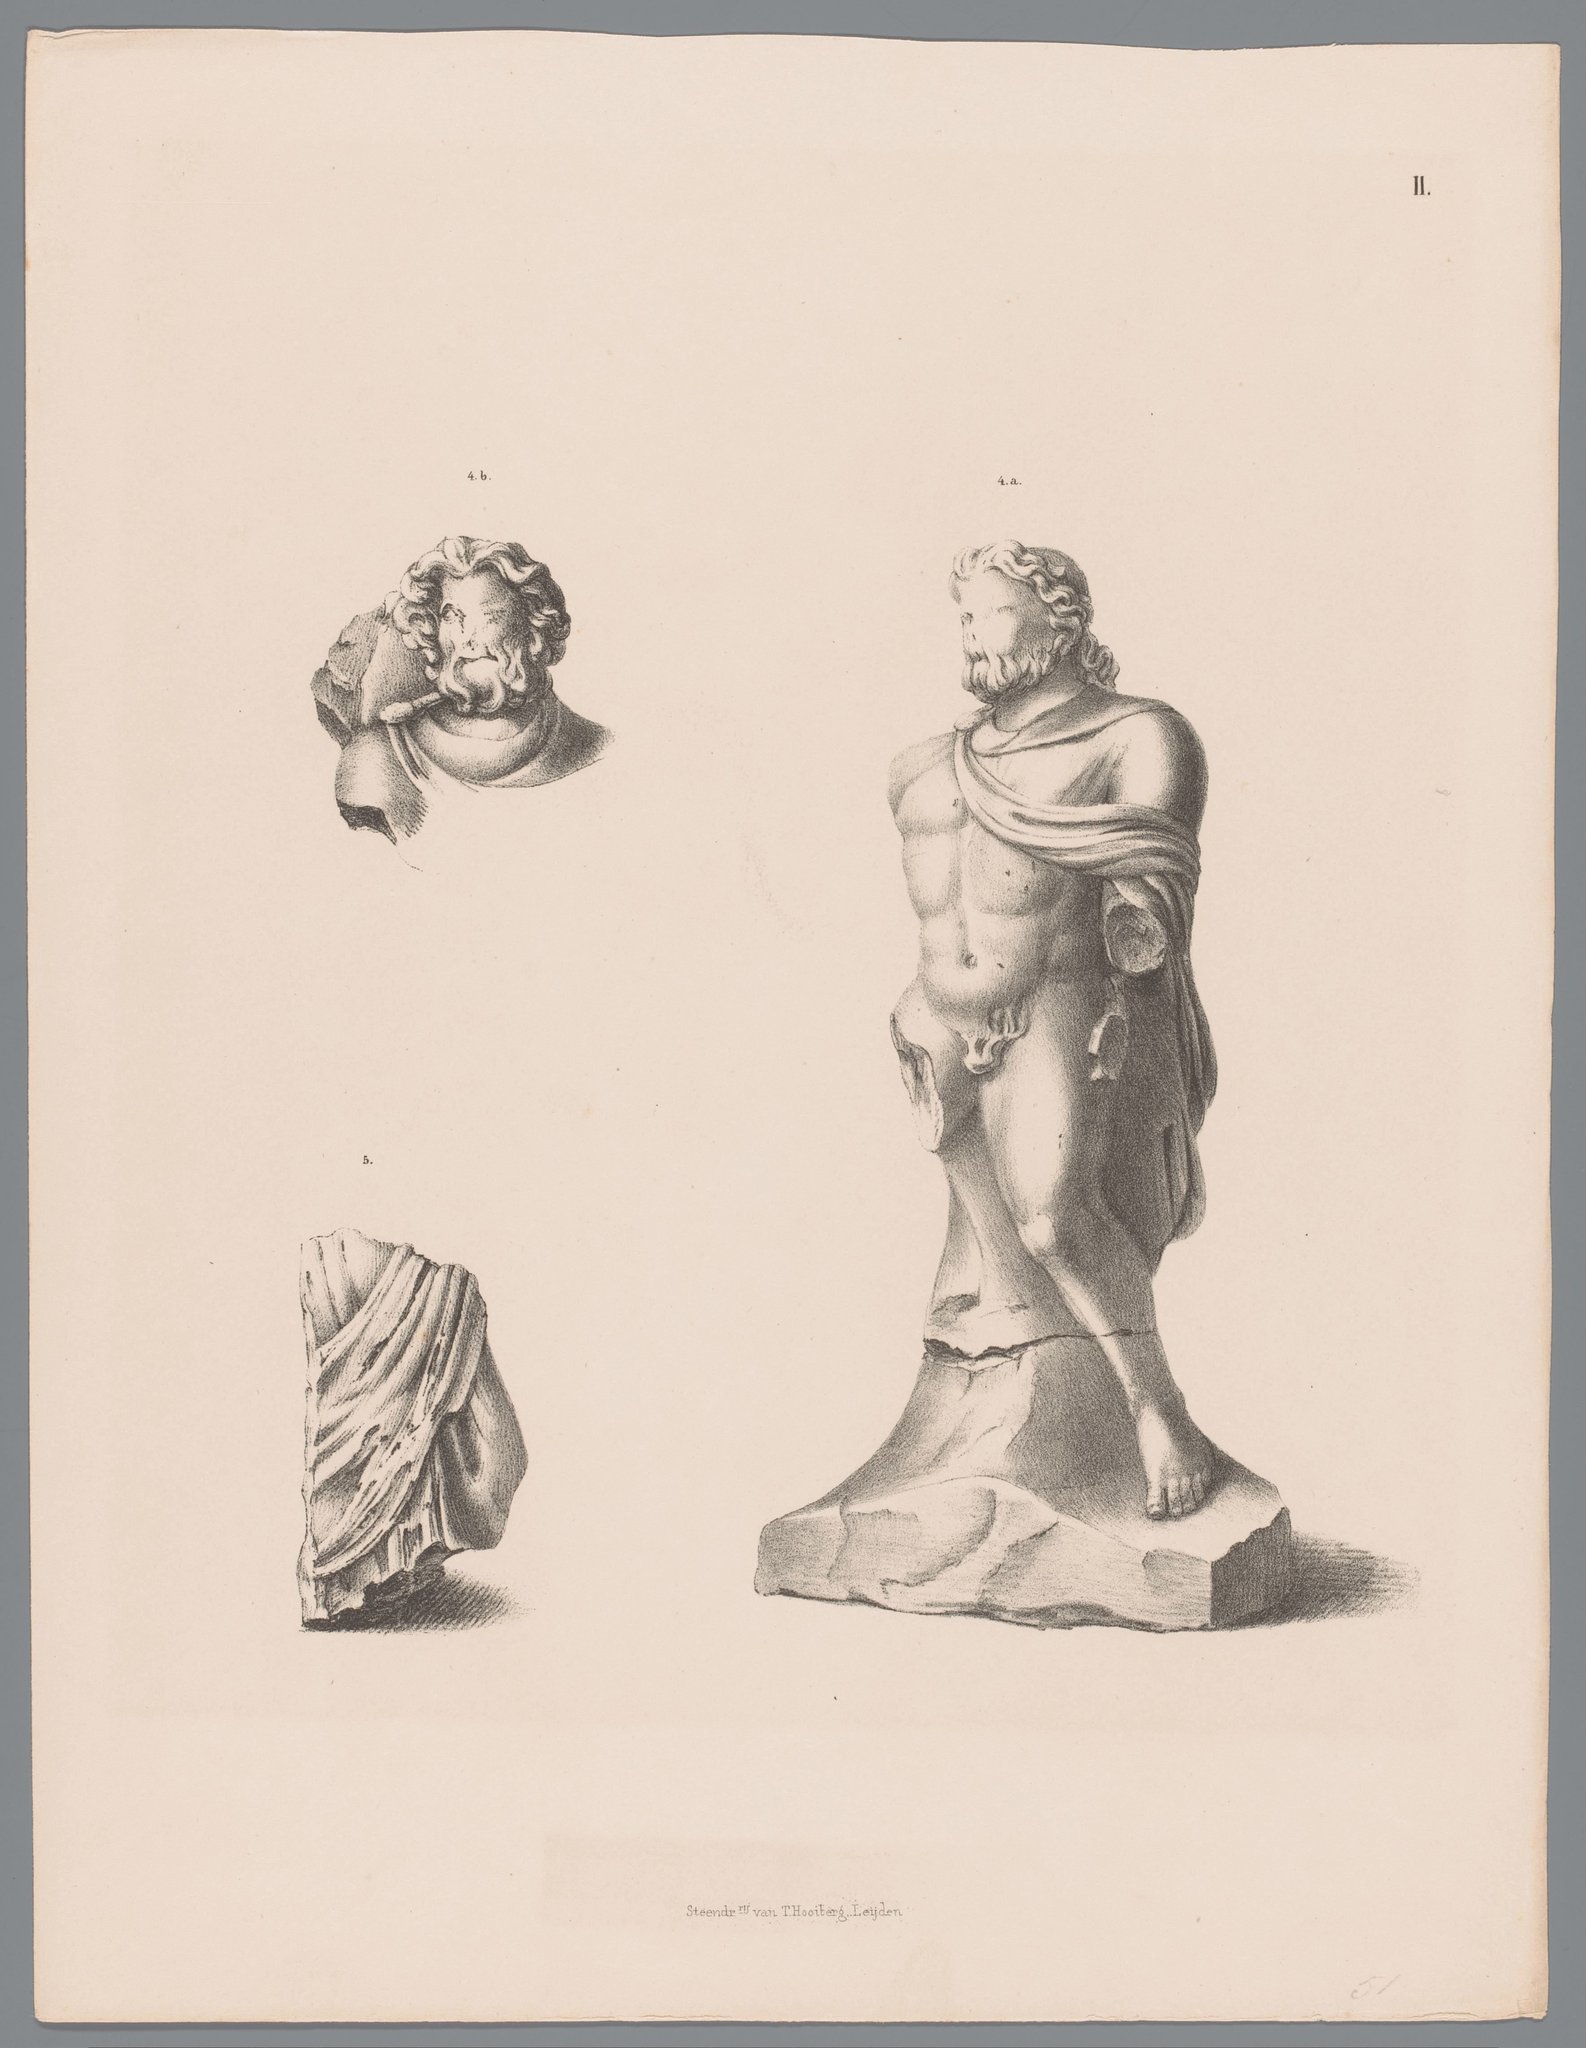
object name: print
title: Romeinse beelden en bouwfragmenten uit Zeeland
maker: tiemen hooiberg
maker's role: painter, print maker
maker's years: 1809-1897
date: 1843-1845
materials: paper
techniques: lithograph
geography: leiden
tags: monument, statue, zeeland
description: Deze platen zijn gebruikt in: De Romeinsche beelden en gedenksteenen van Zeeland... / beschreven en opgehelderd door L.J.F. Janssen, dl. II: platen. Ook gebruikt in: Afbeeldingen der op de godsdienst betrekking hebbende gedenkstukken van steen, ... behoorende bij J. Ab Utrecht Dresselhuis, De godsdiensten der aloude Zeelanders ..., en L.J.F. Janssen, De Romeinsche beelden en gedenksteenen enz. (Middelburg 1845).